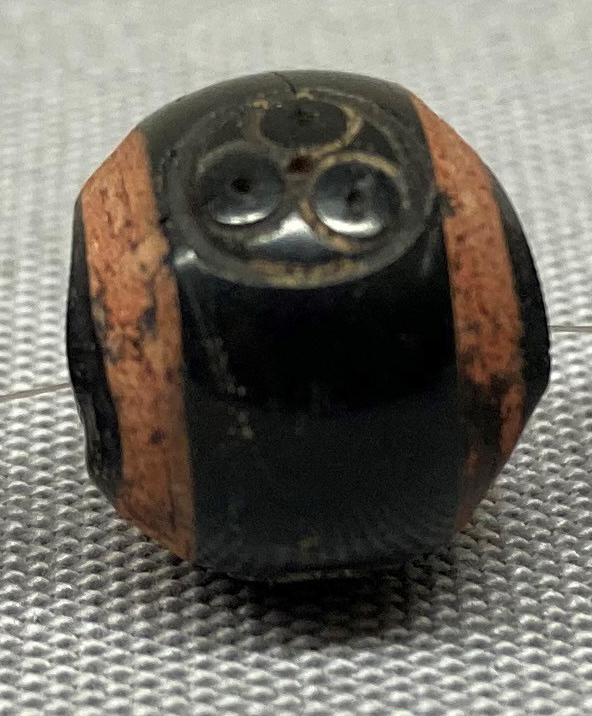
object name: bead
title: Stone Beads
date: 701-1200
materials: stone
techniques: incising, painting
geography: iran